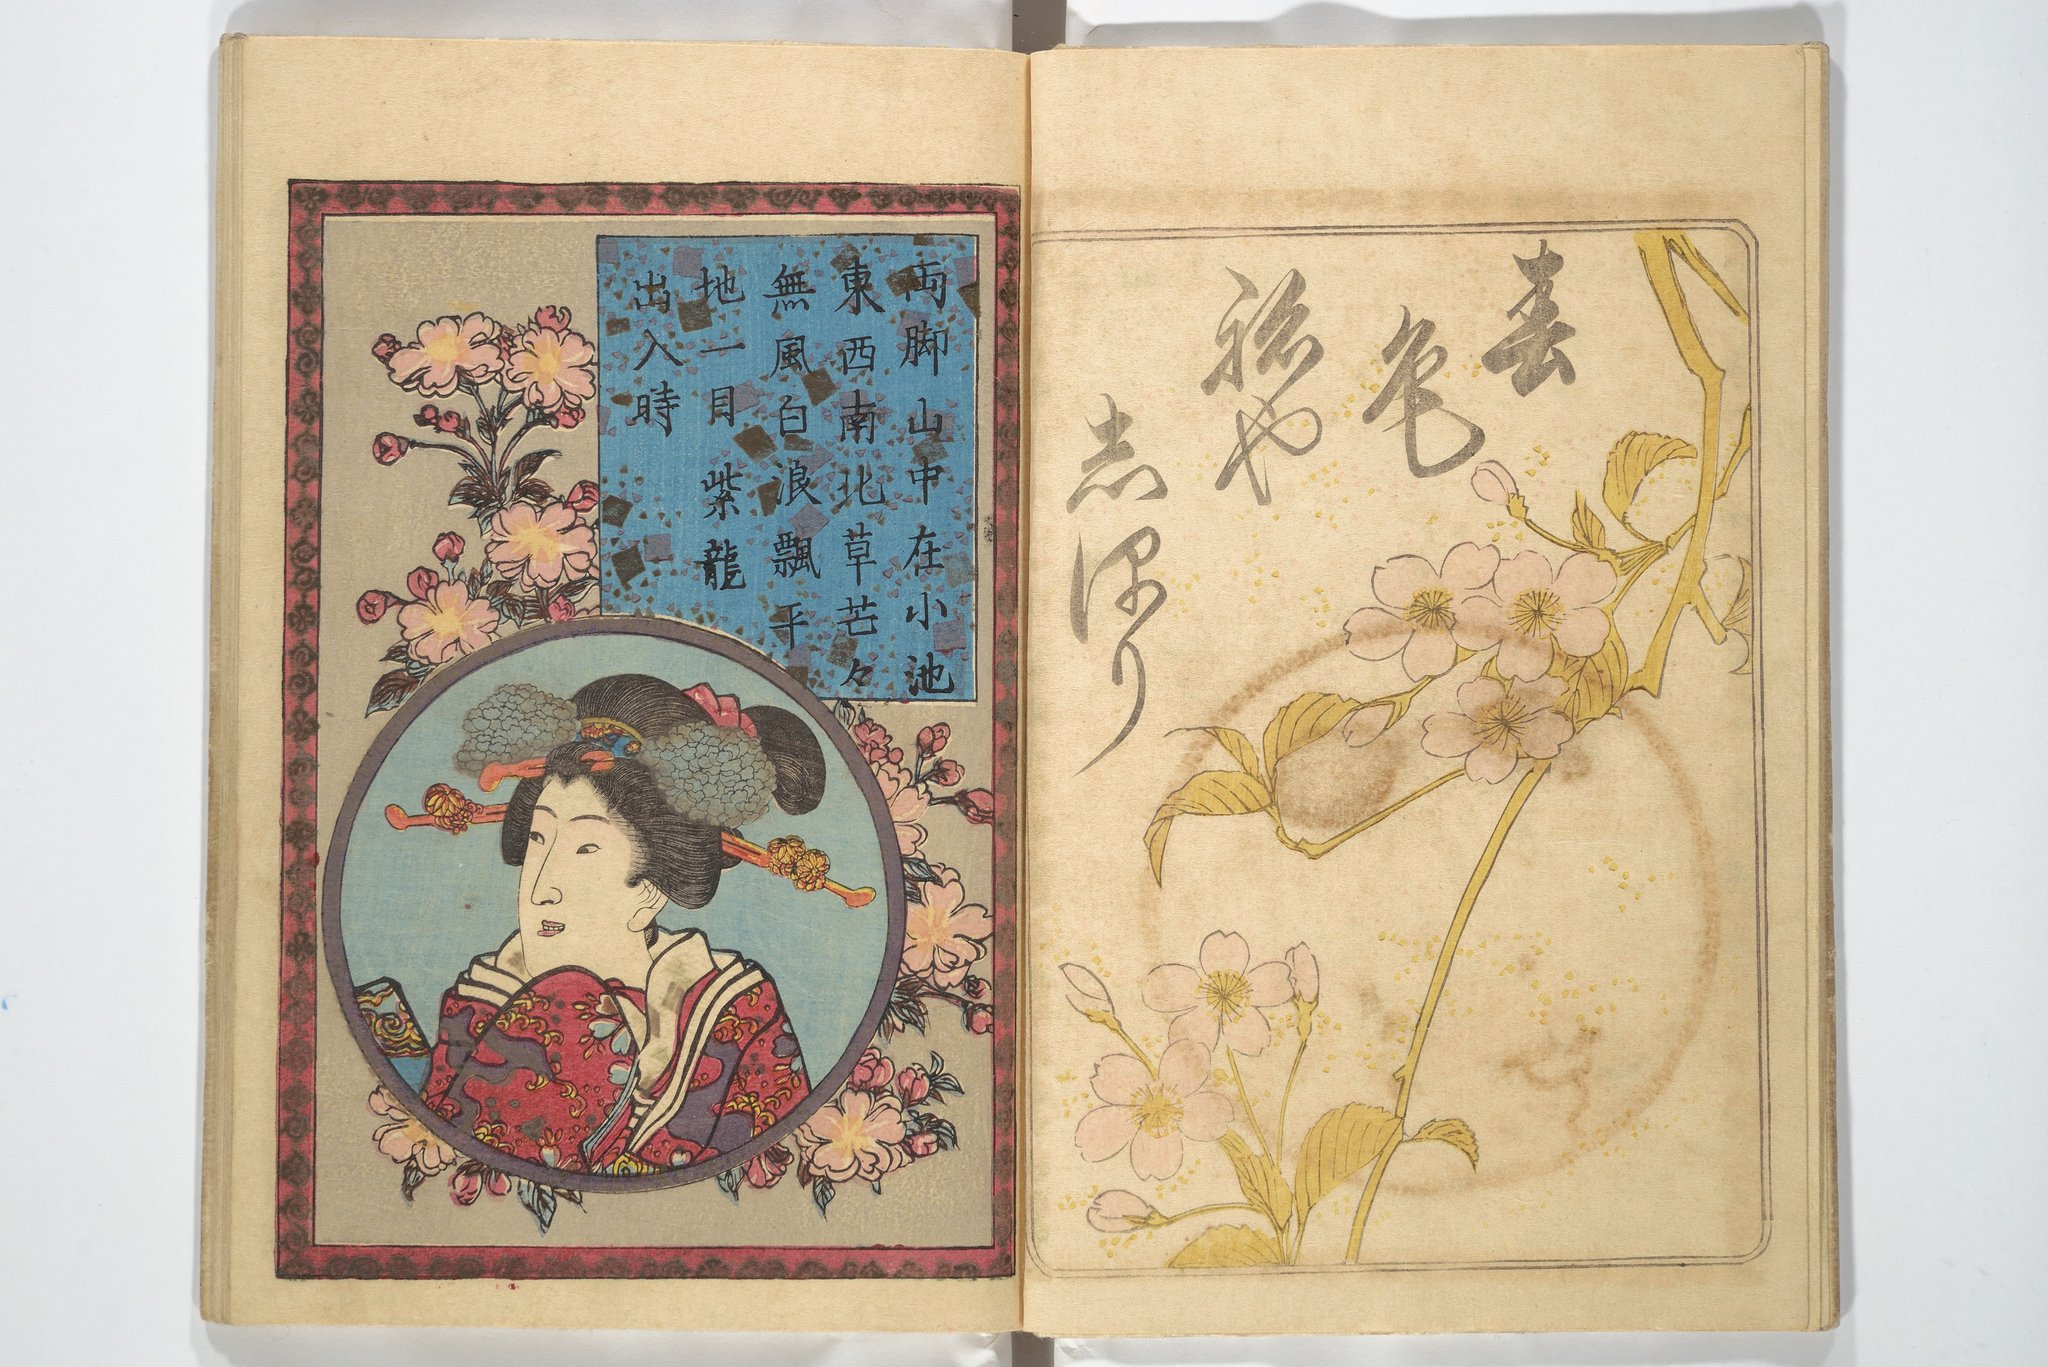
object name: illustrated book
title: A Bedside Guide to the Colors of Love in Spring (Shunshoku neya no shiori) 春色閨の栞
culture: japanese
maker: utagawa kunisada 歌川国貞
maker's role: artist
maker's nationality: japanese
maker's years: 1786-1864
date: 1850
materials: ink, paper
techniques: woodblock print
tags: women,flowers